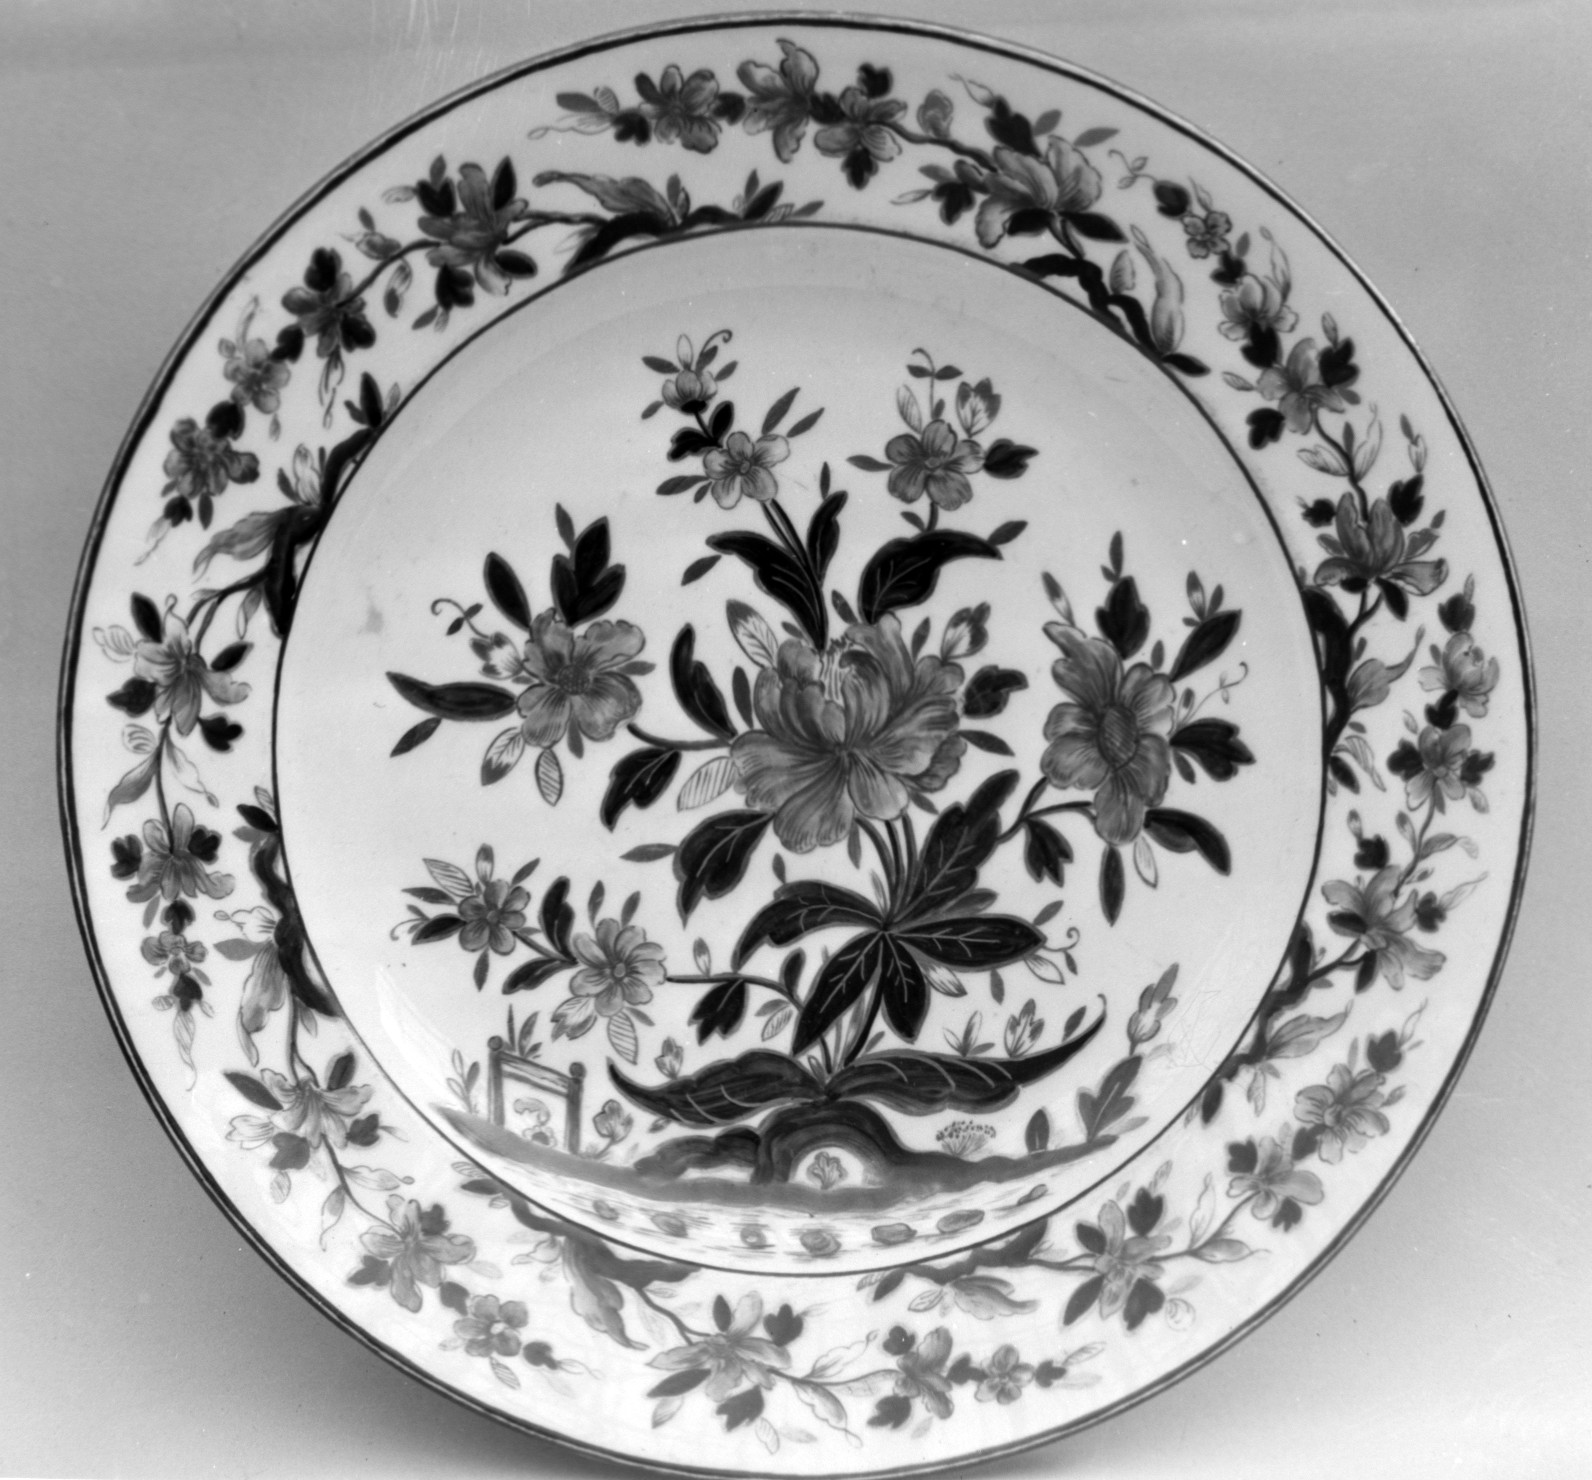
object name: plate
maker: nymphenburg porcelain manufactory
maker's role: manufactory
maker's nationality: german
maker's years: 1747-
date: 1701-1800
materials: hard paste porcelain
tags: flowers